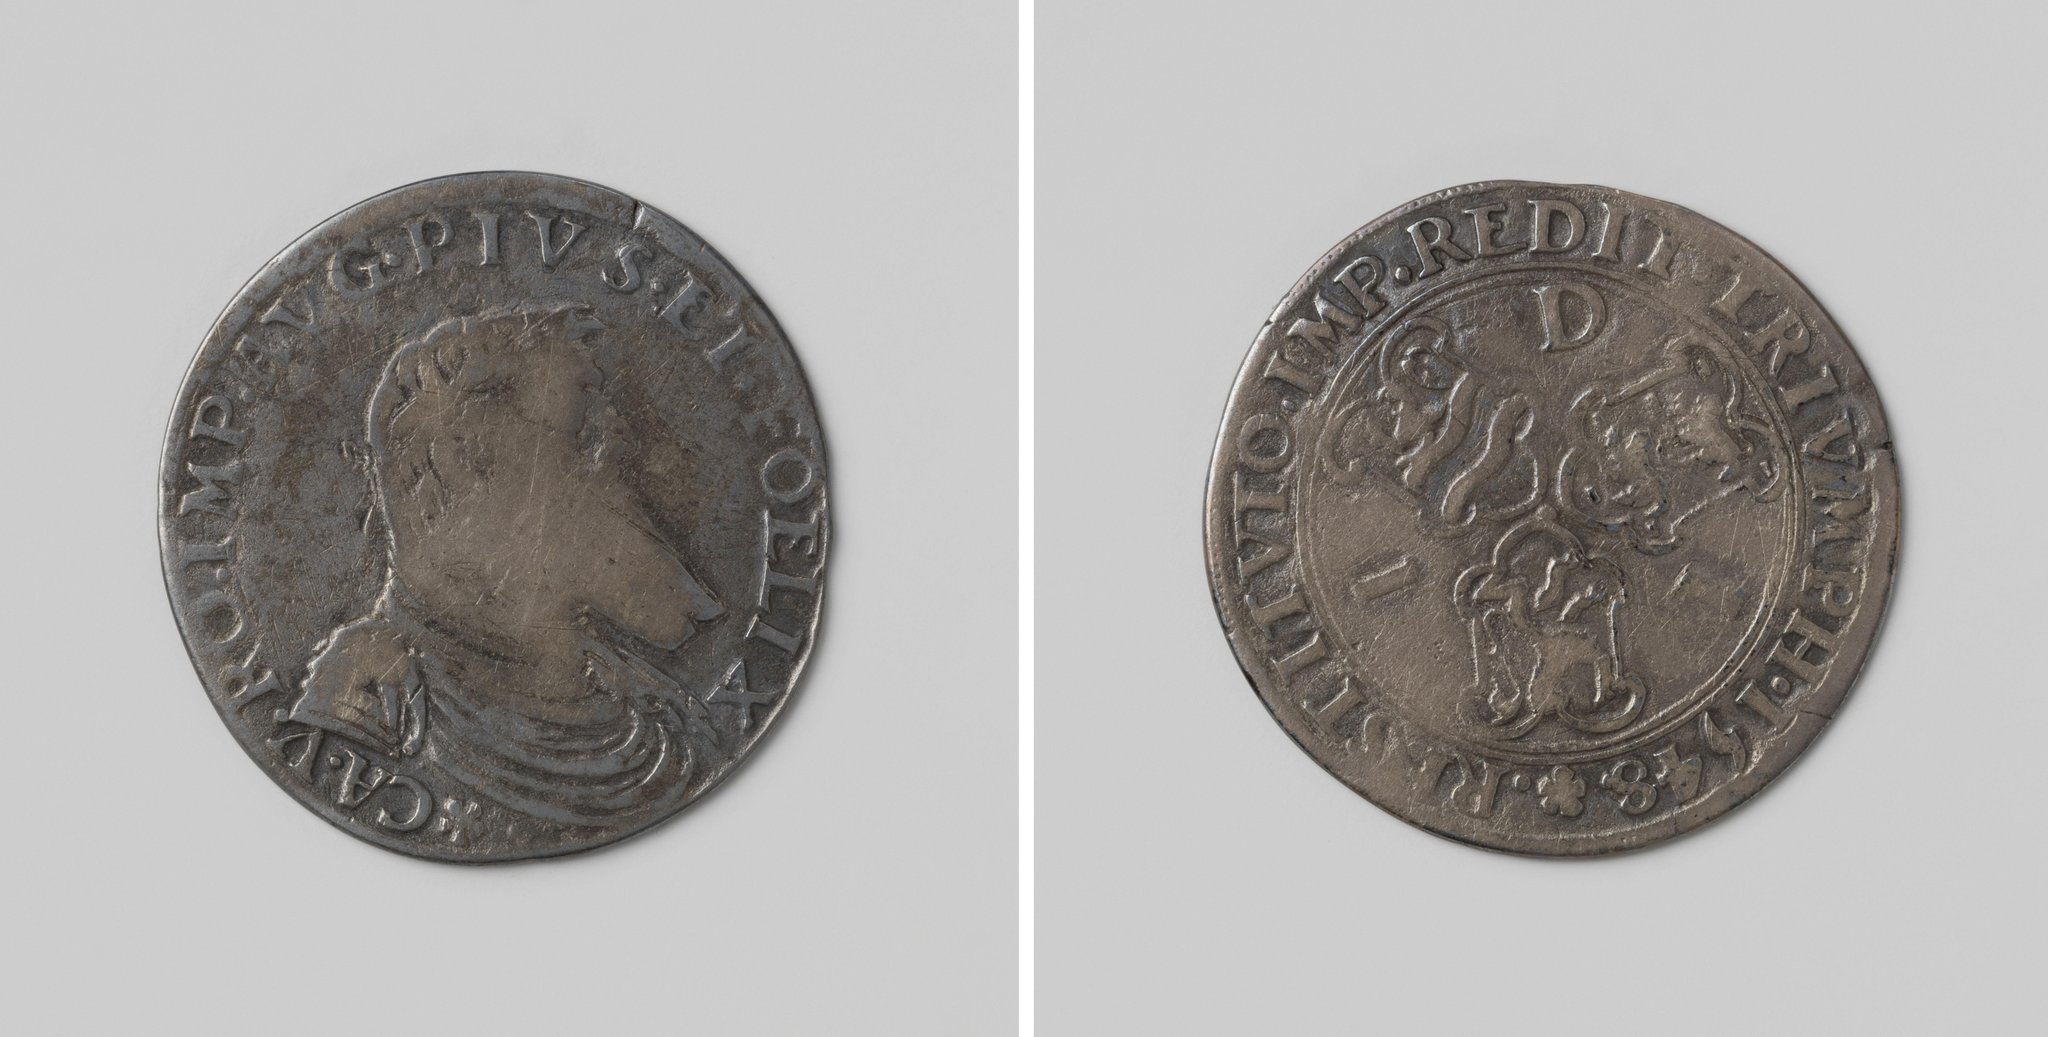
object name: jeton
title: Herstel van de vrede in Duitsland op het Interim van Augsburg, rekenpenning ten behoeve van Mr. Jacob de Jonge, auditeur van de rekenkamer van Holland te 's-Gravenhage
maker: Anonymous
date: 1548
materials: silver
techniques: striking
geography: netherlands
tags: ghent, charles v (holy roman emperor and king of spain), the hague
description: Zilveren penning. Voorzijde: borststuk man met lauwerkrans binnen omschrift. Keerzijde: drie in kring geplaatste wapenschilden; daartussen letters I, D en I binnen omschrift